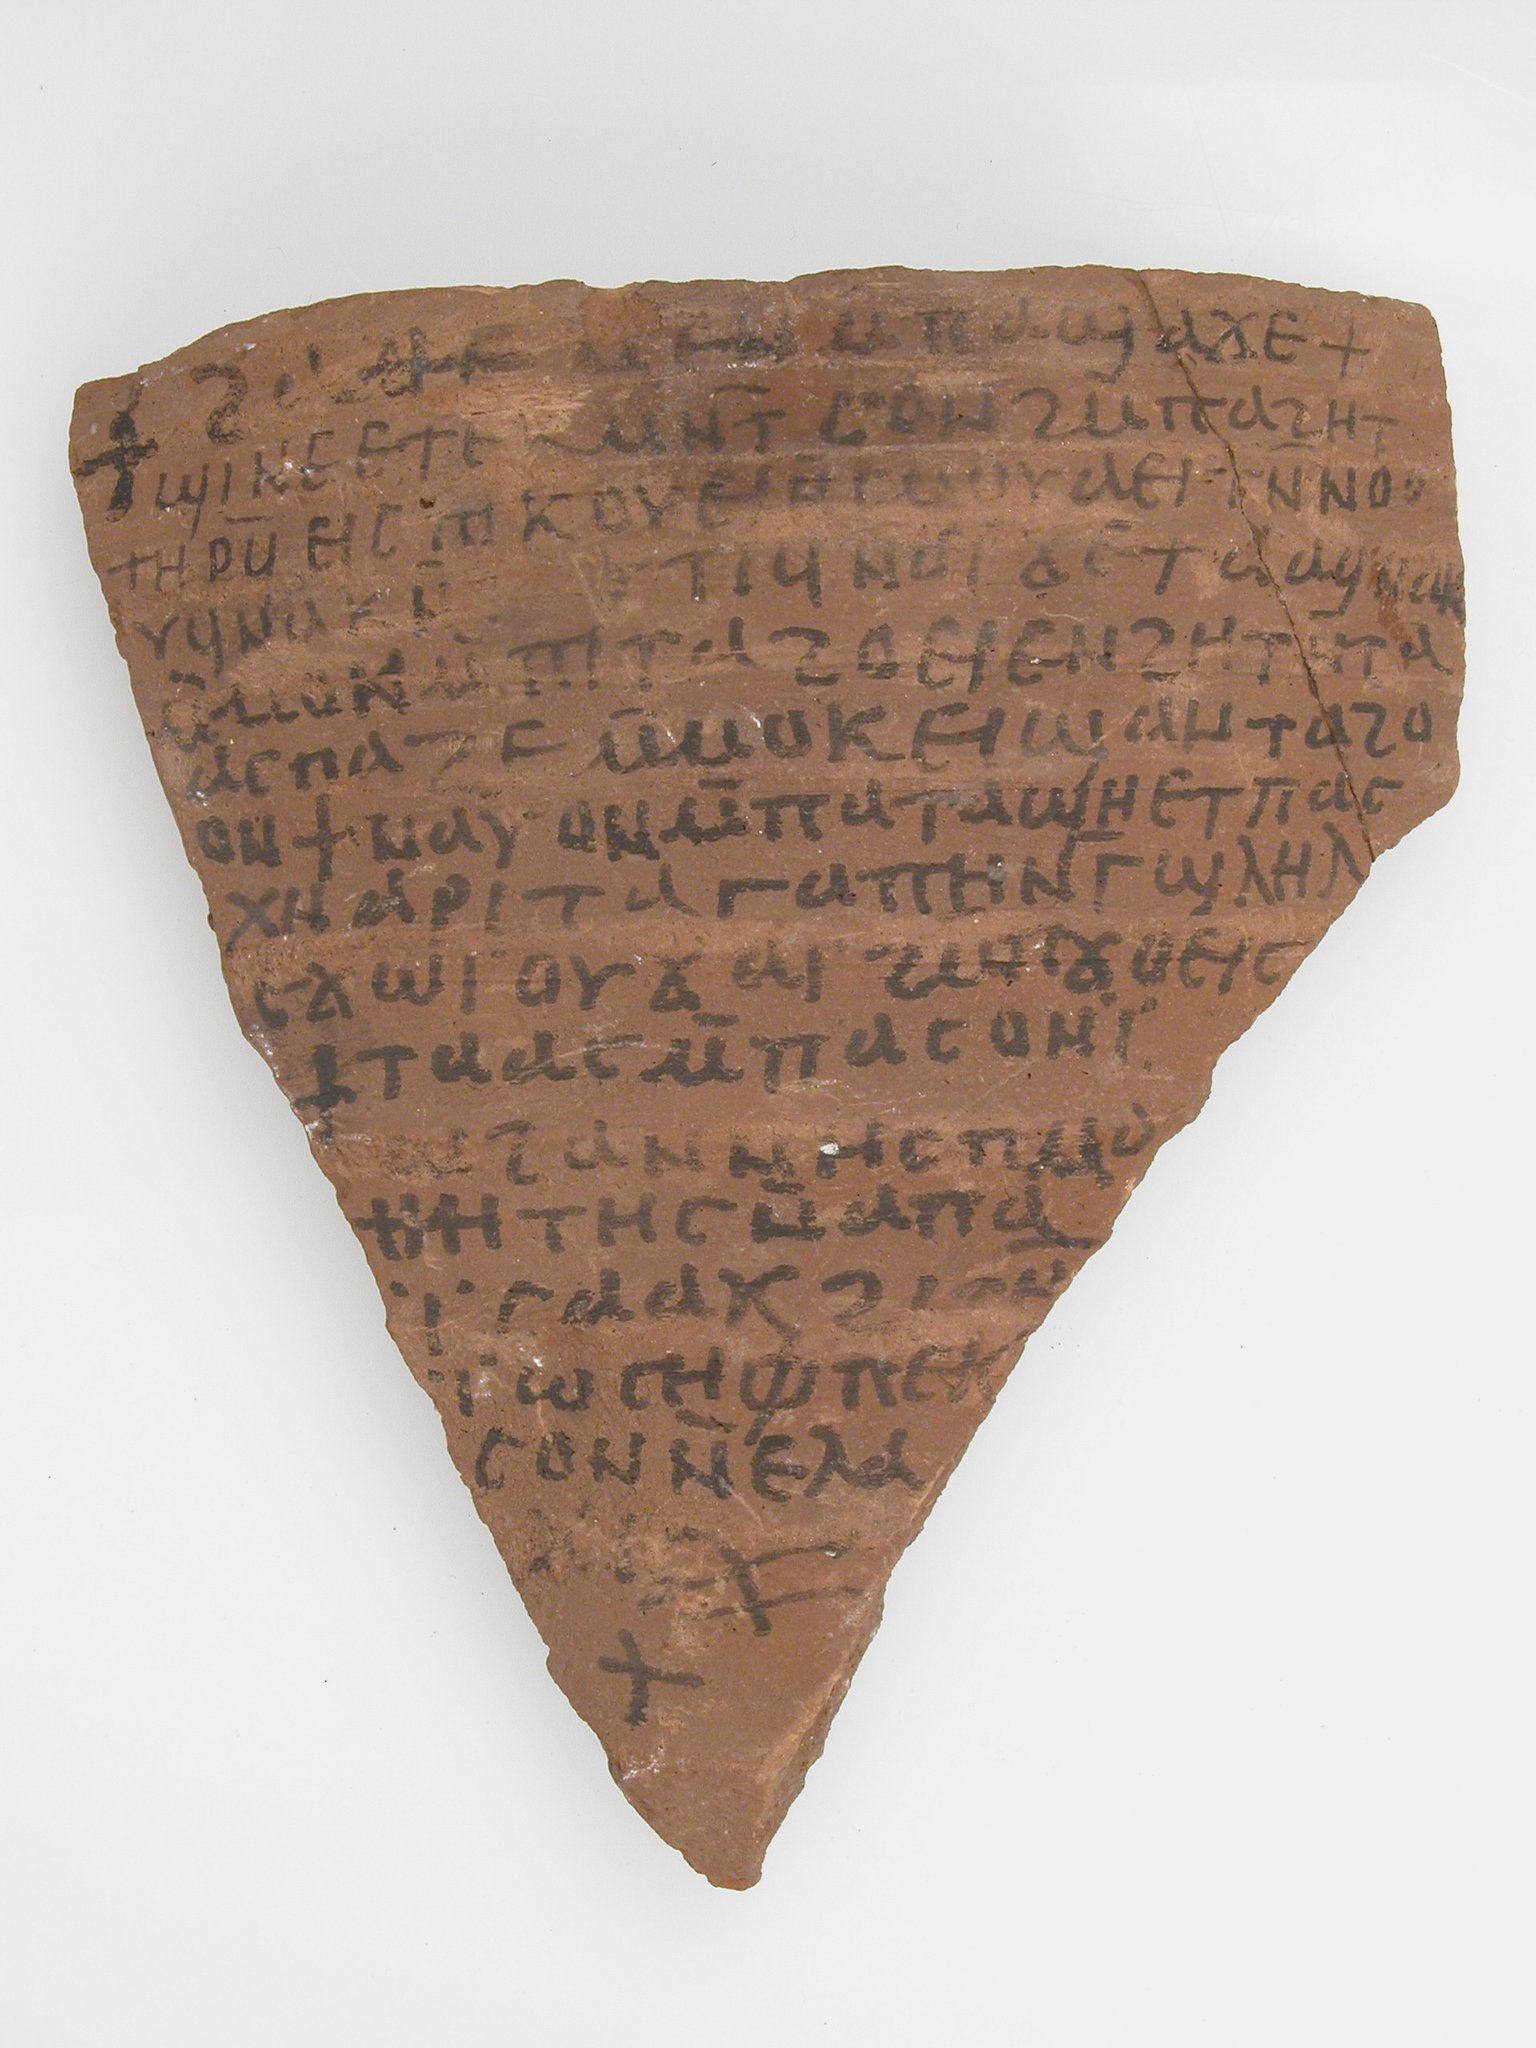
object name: ostrakon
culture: coptic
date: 601-700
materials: ink, pottery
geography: egypt